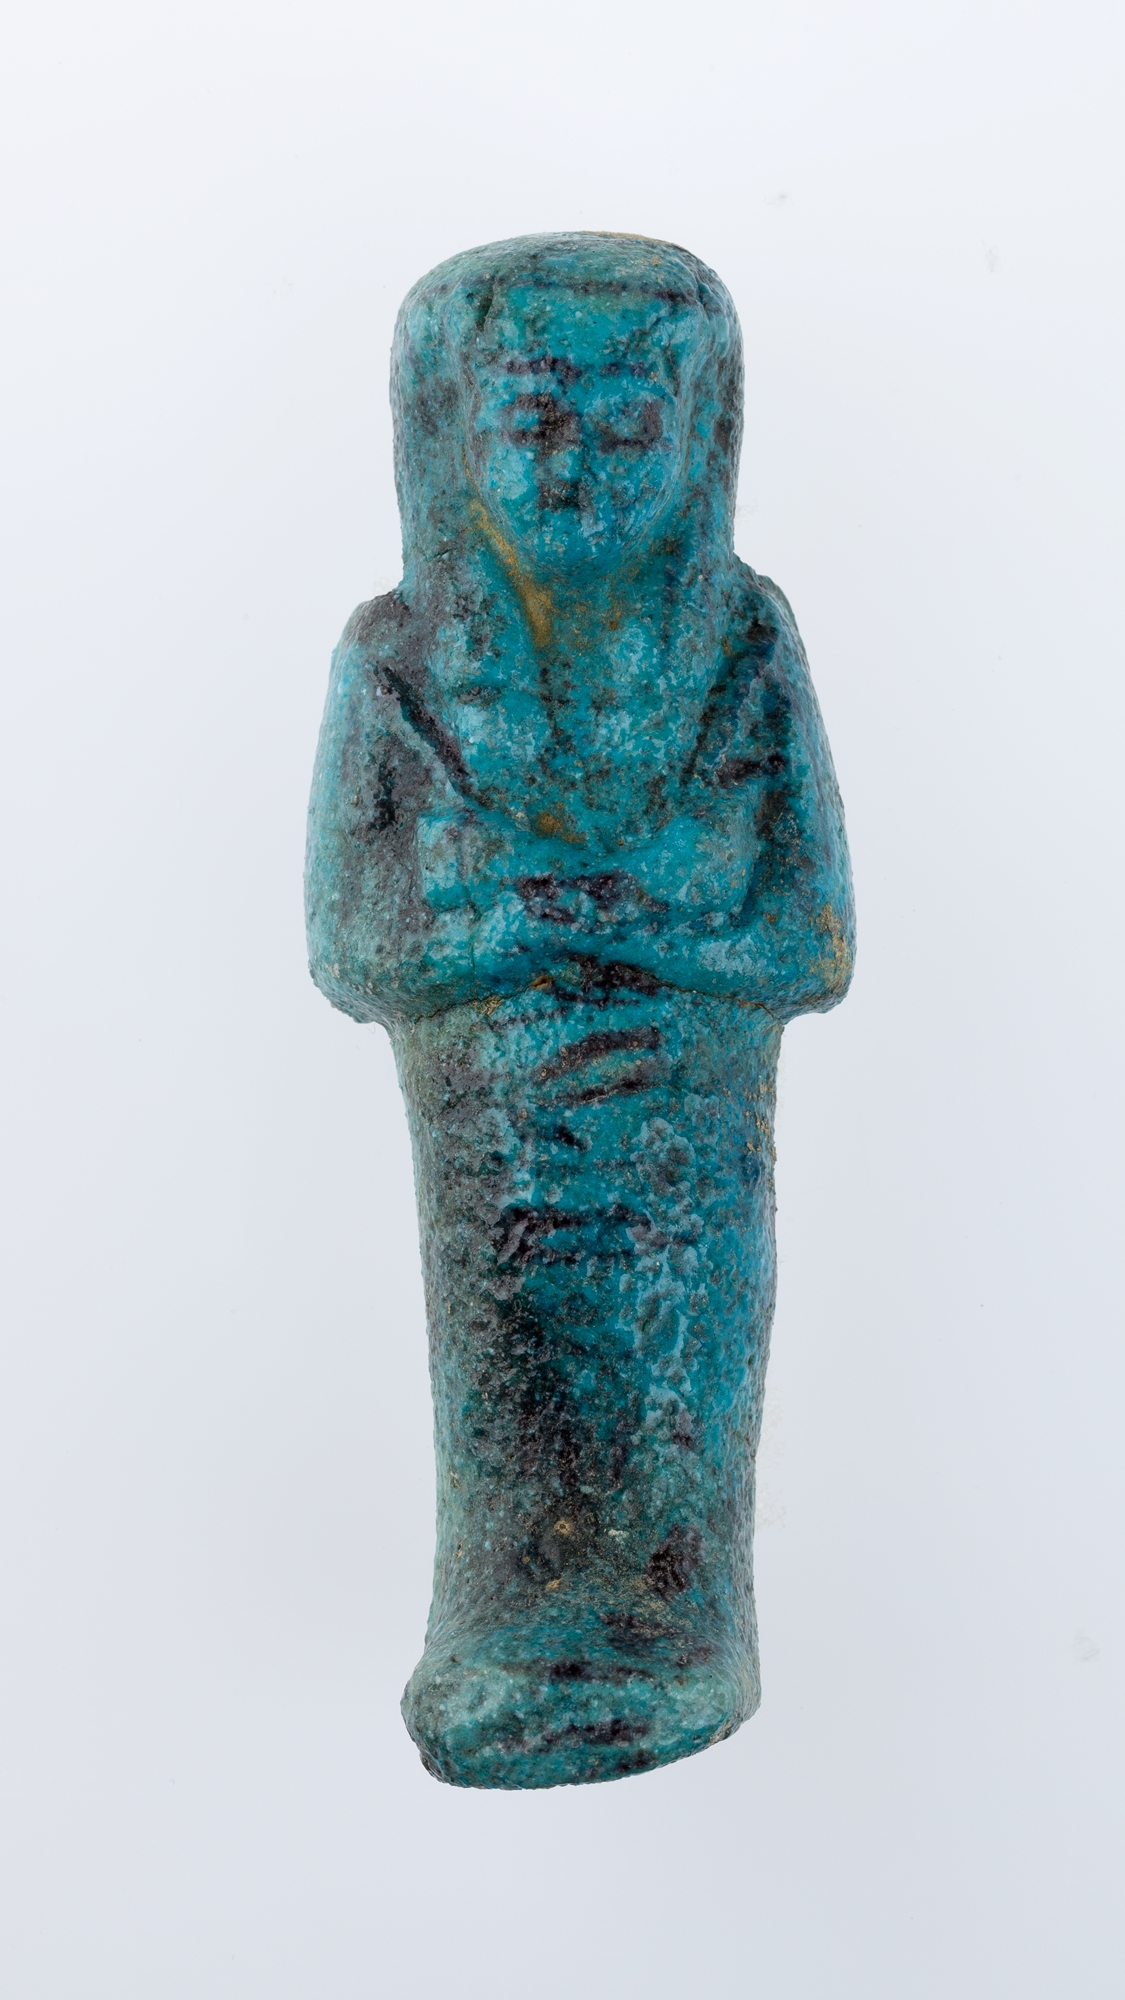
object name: shabti, henettawy c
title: Worker Shabti of Henettawy (C), Daughter of Isetemkheb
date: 990-970 BCE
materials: faience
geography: egypt